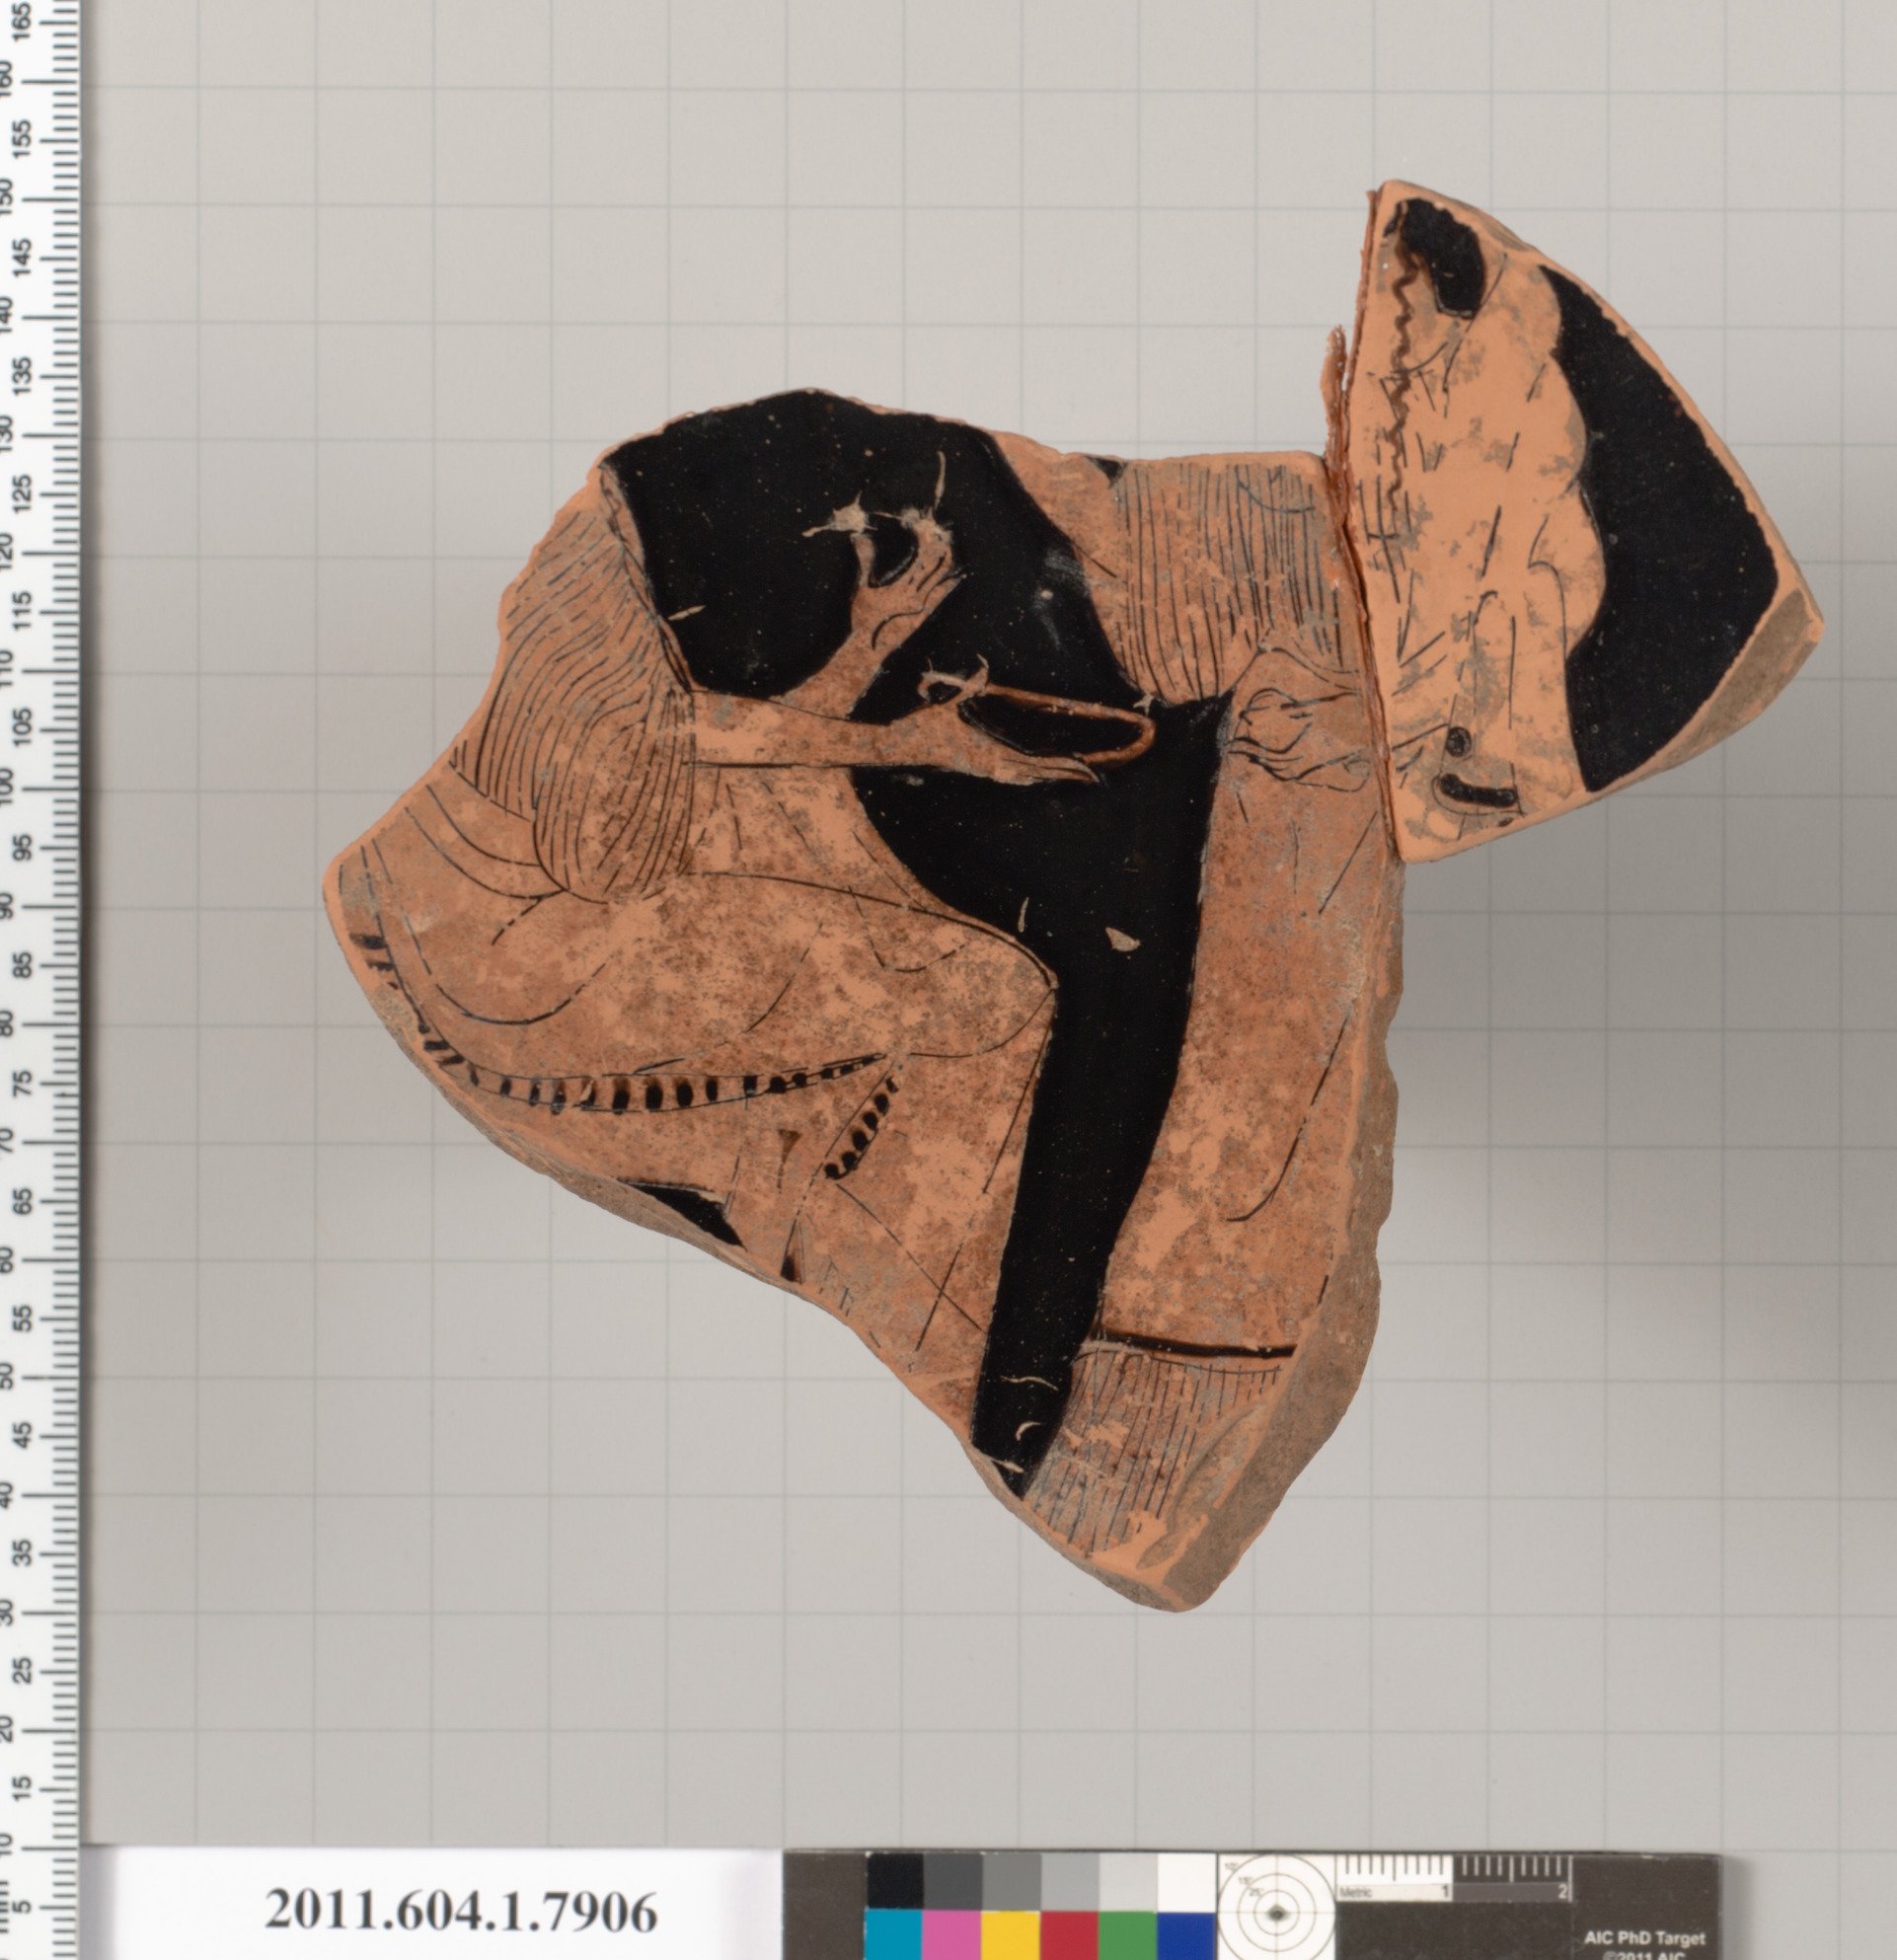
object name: kylix fragment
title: Terracotta fragment of a kylix (drinking cup)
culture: greek, attic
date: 475-451 BCE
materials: terracotta